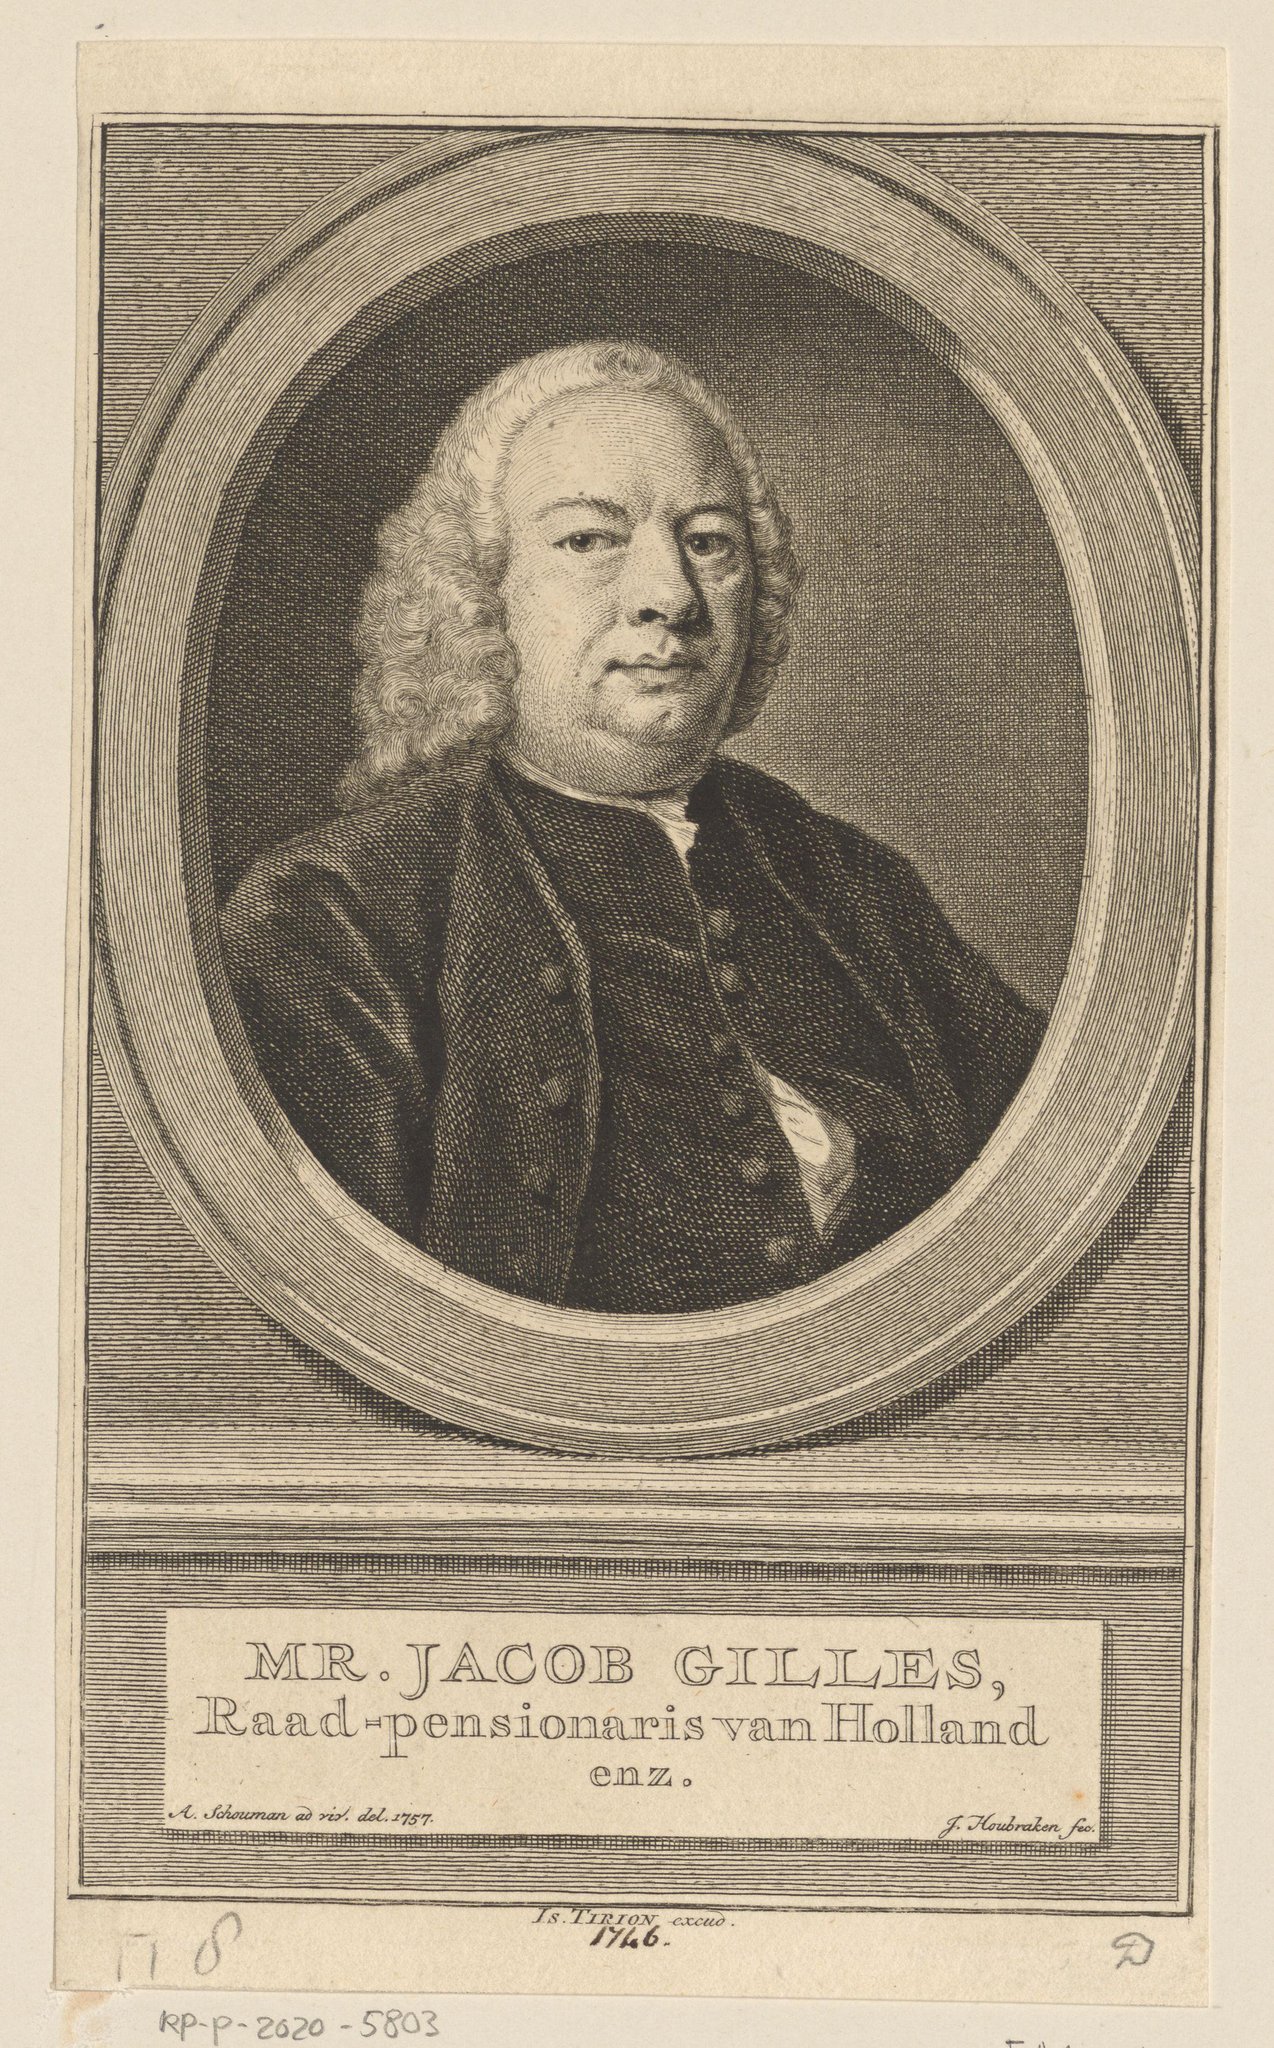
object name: print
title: Portret van Jacob Gilles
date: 1749-1759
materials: paper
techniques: engraving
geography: amsterdam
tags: historical persons, politician, e.g. party leader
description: Prent uit: Wagenaar, Jan. Vaderlandsche historie, vervattende de geschiedenissen der nu Vereenigde Nederlanden, inzonderheid die van Holland (...). 21 dln. Amsterdam: Isaak Tirion, [1749-1759].